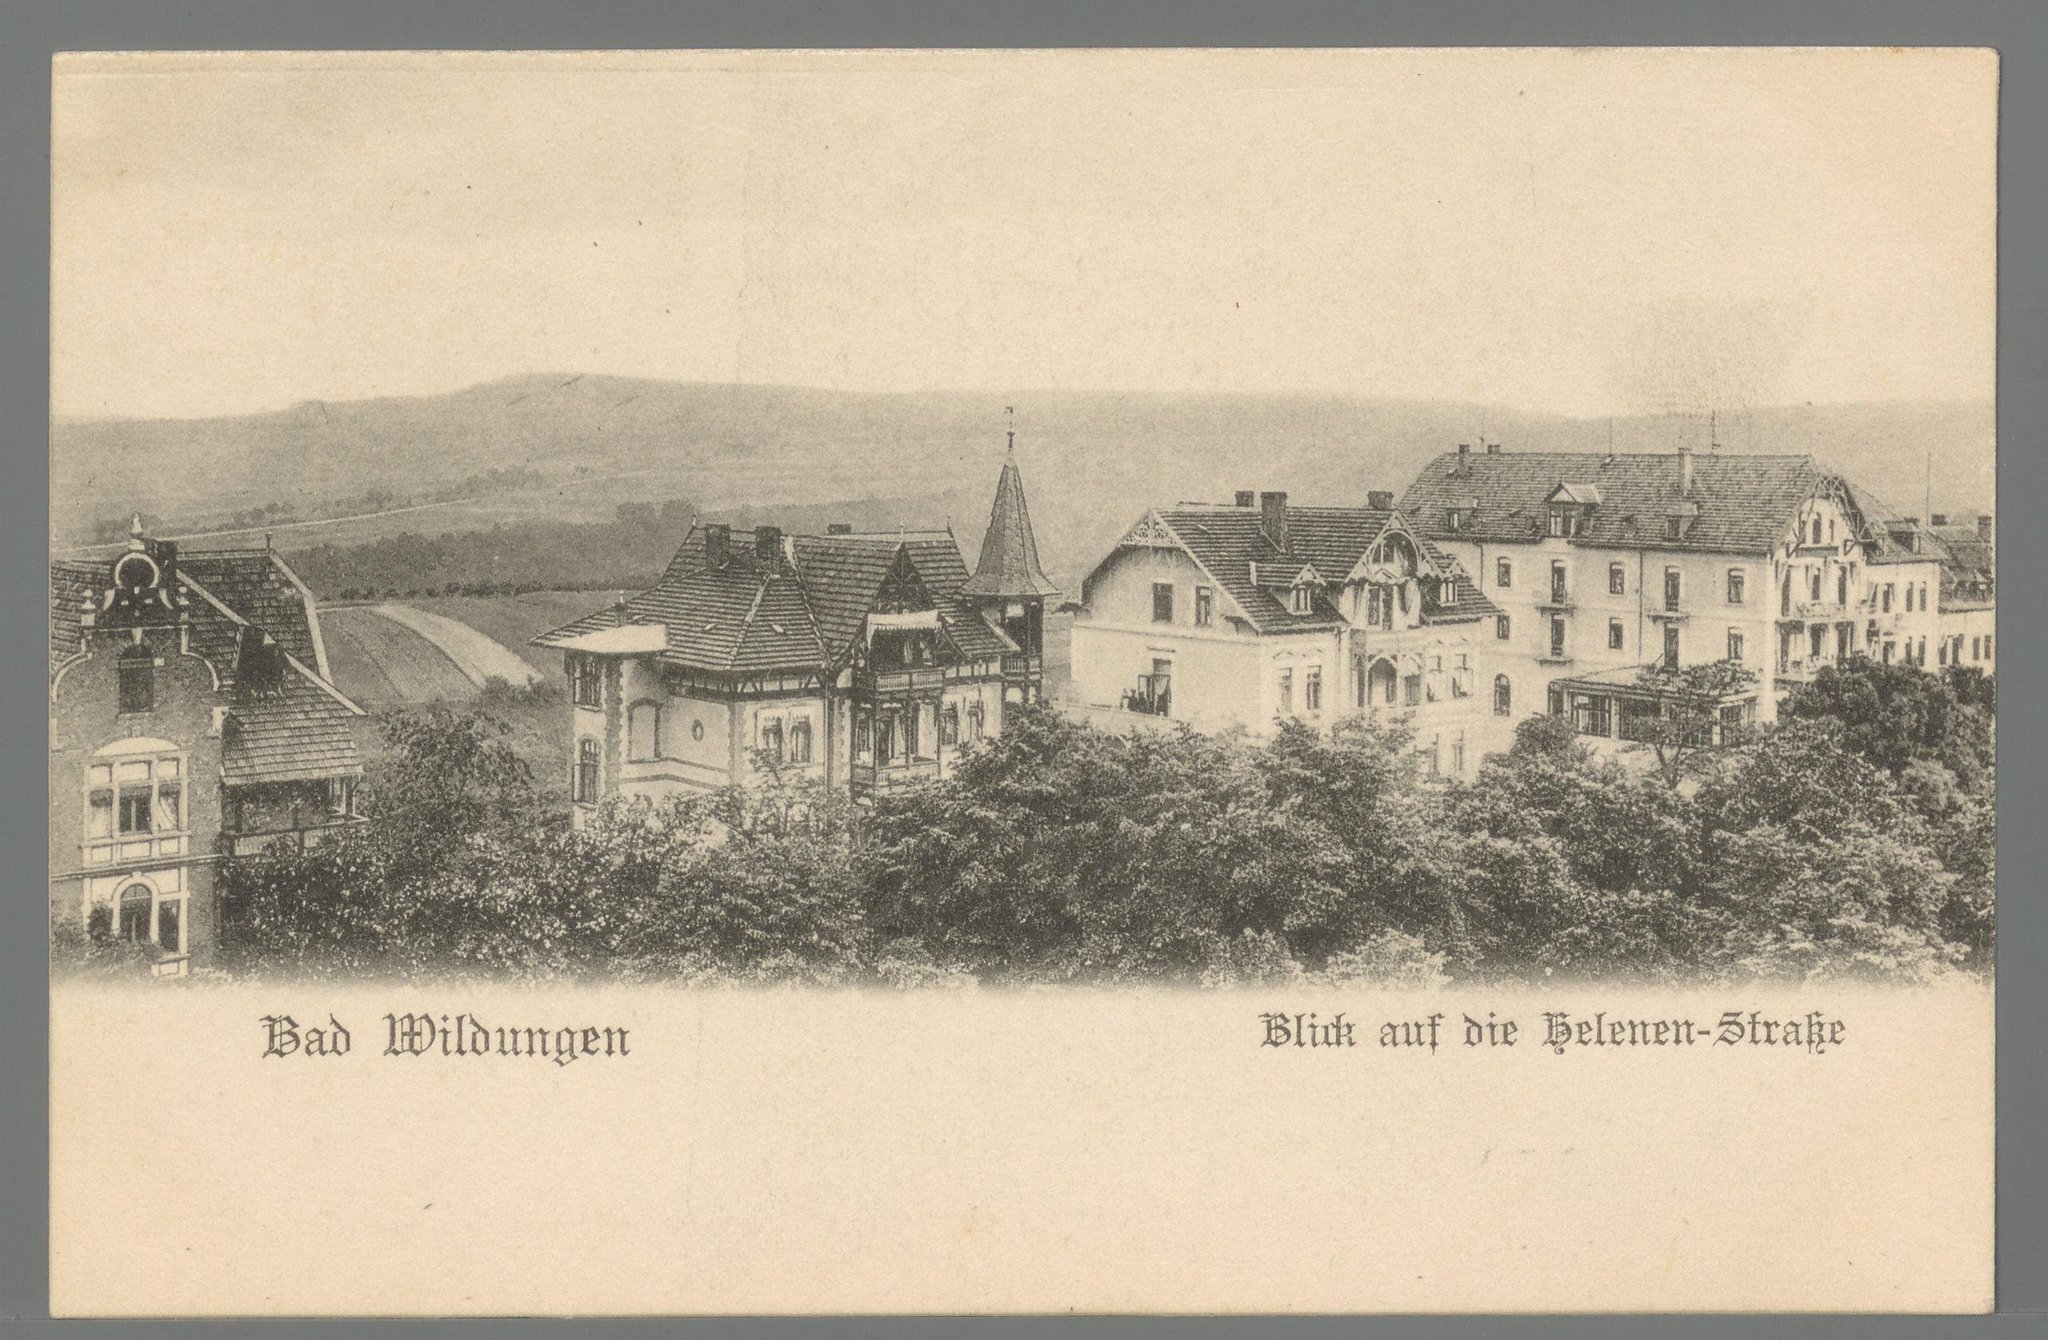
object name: ansichtkaart, prentbriefkaart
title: Bad Wildungen Blick auf die Helenenstraße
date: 1870-1905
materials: cardboard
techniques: photograph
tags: village street